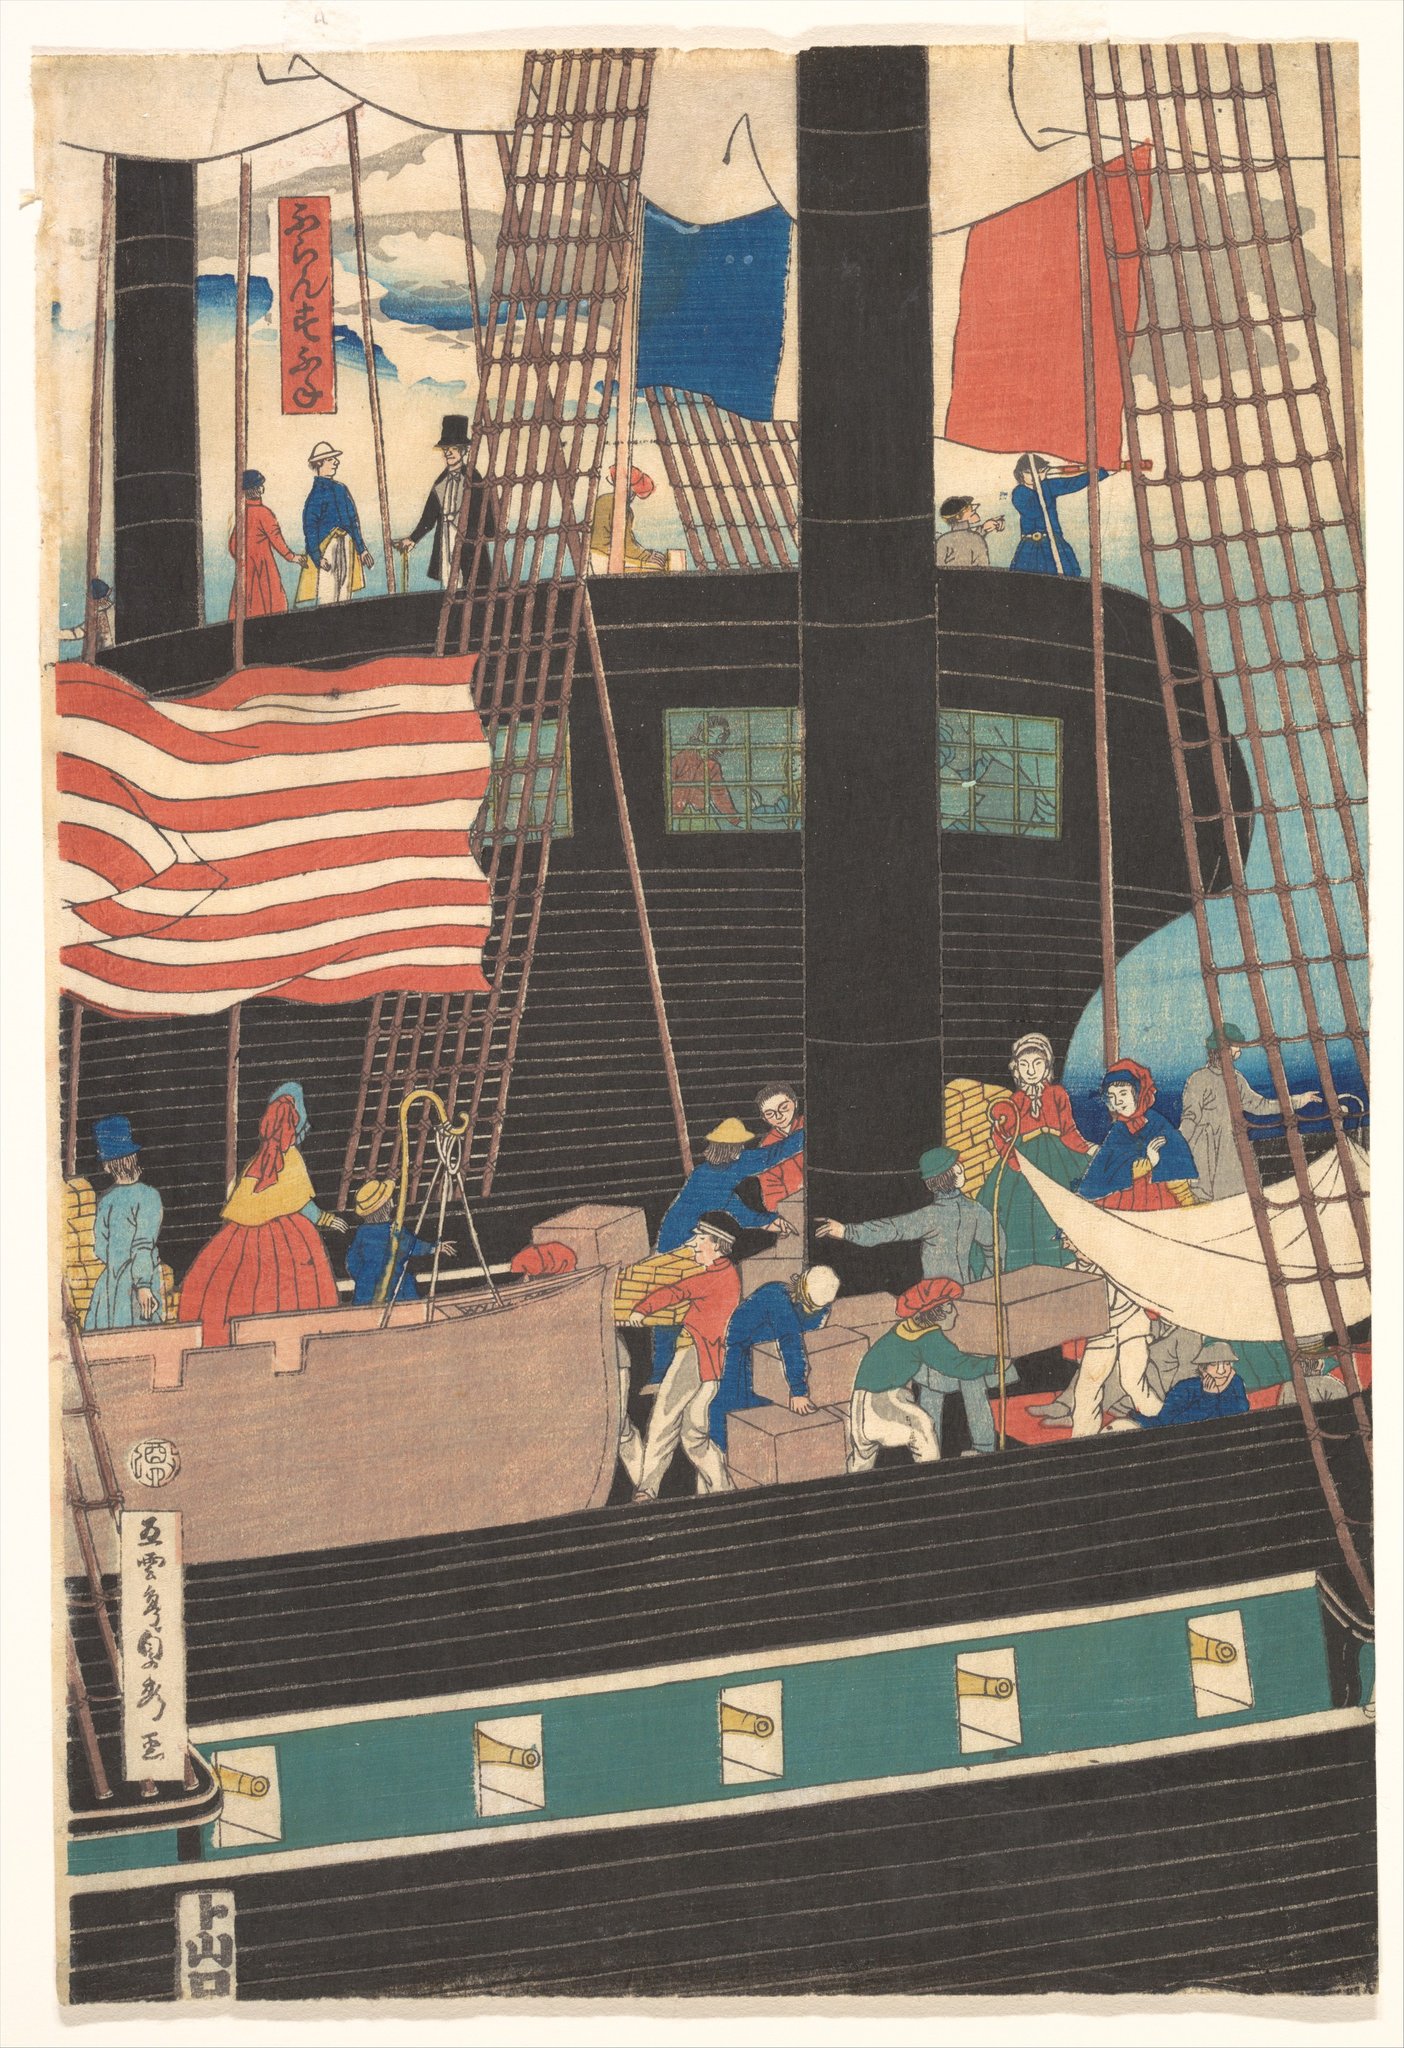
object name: print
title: Yokohama Trade: Picture of Westerners Shipping Cargo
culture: japanese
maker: utagawa (gountei) sadahide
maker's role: artist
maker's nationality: japanese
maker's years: 1807-1873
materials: ink, paper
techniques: woodblock print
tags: men,women,ships